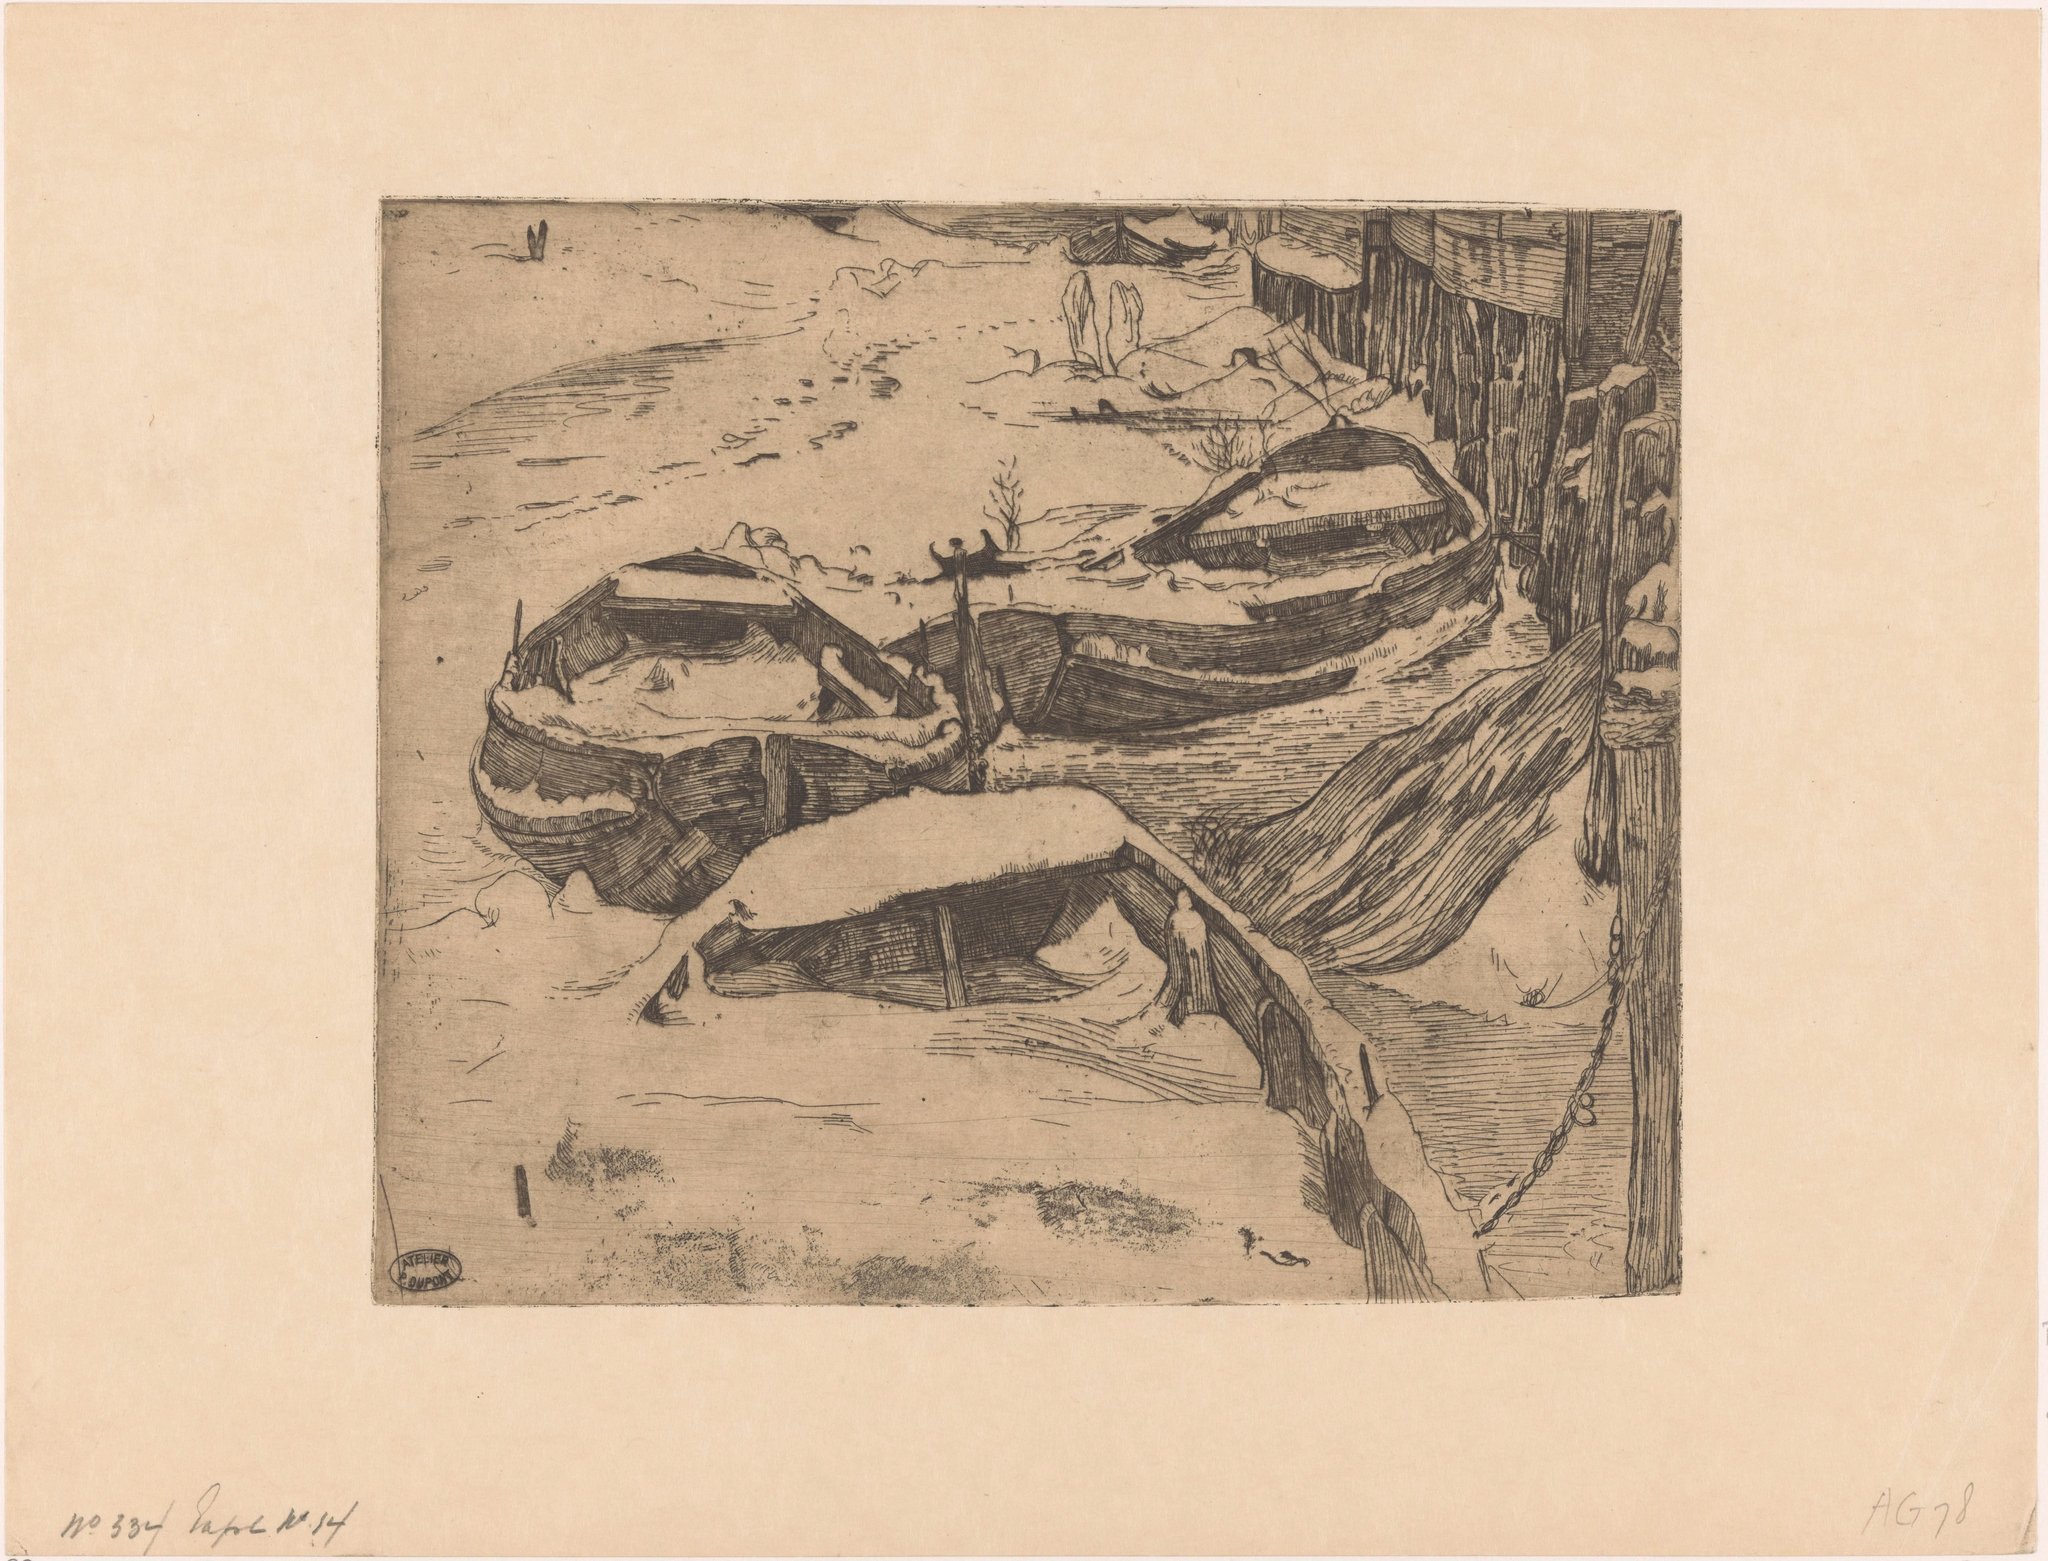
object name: print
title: Drie besneeuwde roeiboten bij een wal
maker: pieter dupont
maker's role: draughtsman, print maker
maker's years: 1870-1911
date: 1801-1895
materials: paper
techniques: intaglio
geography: amsterdam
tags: rowing-boat, canoe, etc., snow, ice ~ state of water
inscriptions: workshop stamp: ‘ATELIER P. DUPONT’